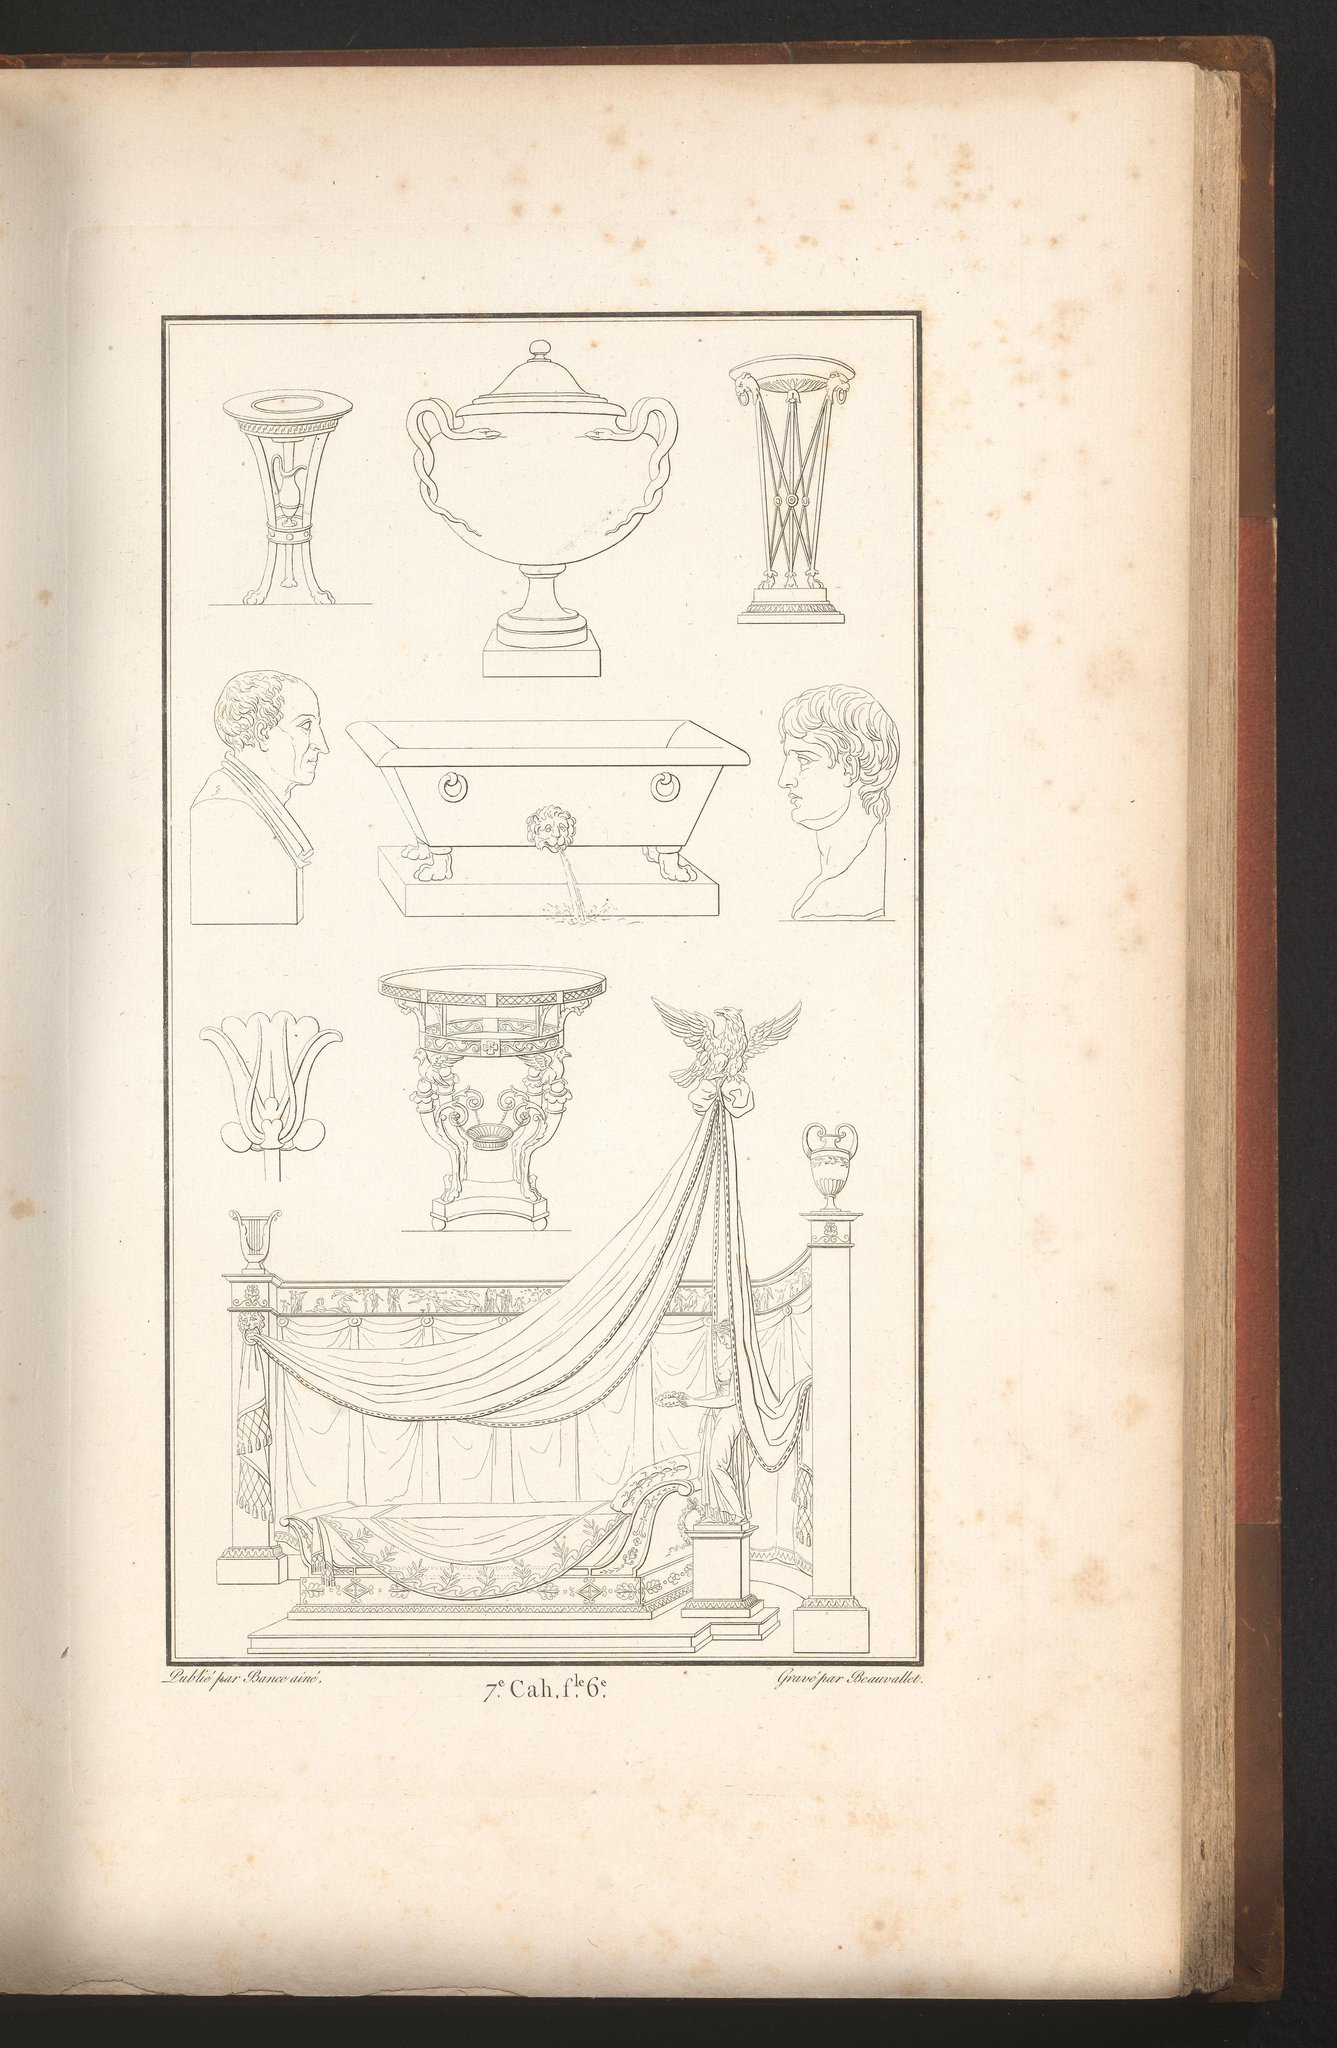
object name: ornament print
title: Diverse ornamenten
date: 1820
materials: paper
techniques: etching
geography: paris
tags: ornaments ~ art, bed, couch, sofa, settee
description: Ornamentprent met diverse objecten, onderaan een ligbed met gordijnen. Onderdeel (7e. Cah. f.le 6) van het prentalbum met twee series van in totaal 138 ornamentprenten door Beauvallet en Normand, 'Fragmens d'Ornemens dans le Style Antique'.